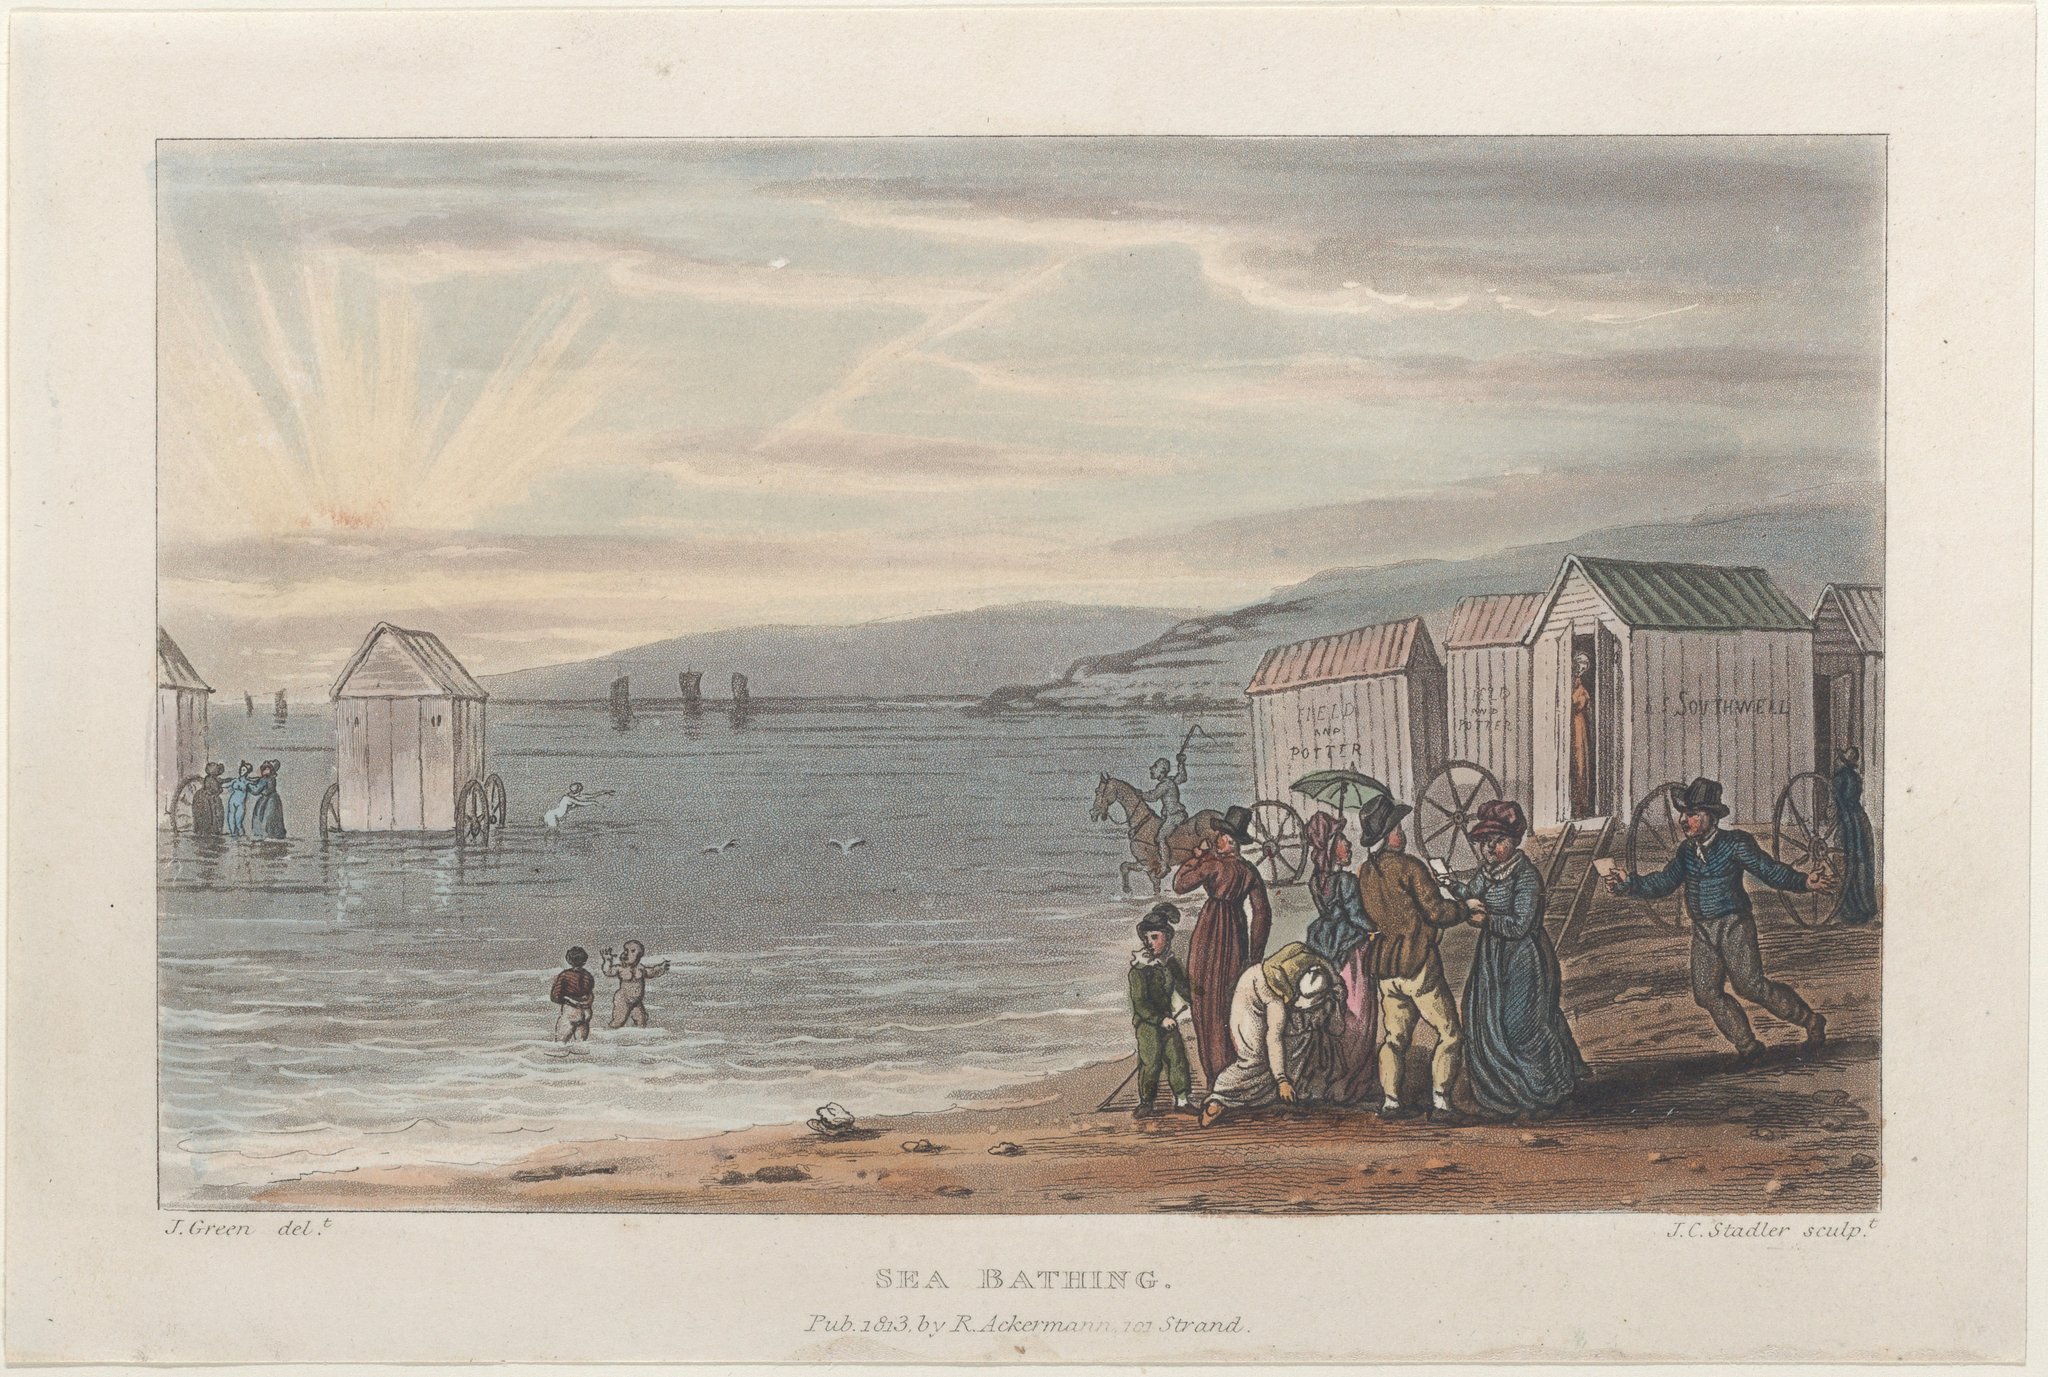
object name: print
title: Sea Bathing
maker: thomas rowlandson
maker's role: artist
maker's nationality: british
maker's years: 1757-1827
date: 1813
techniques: aquatint, etching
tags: leisure,men,women,beaches